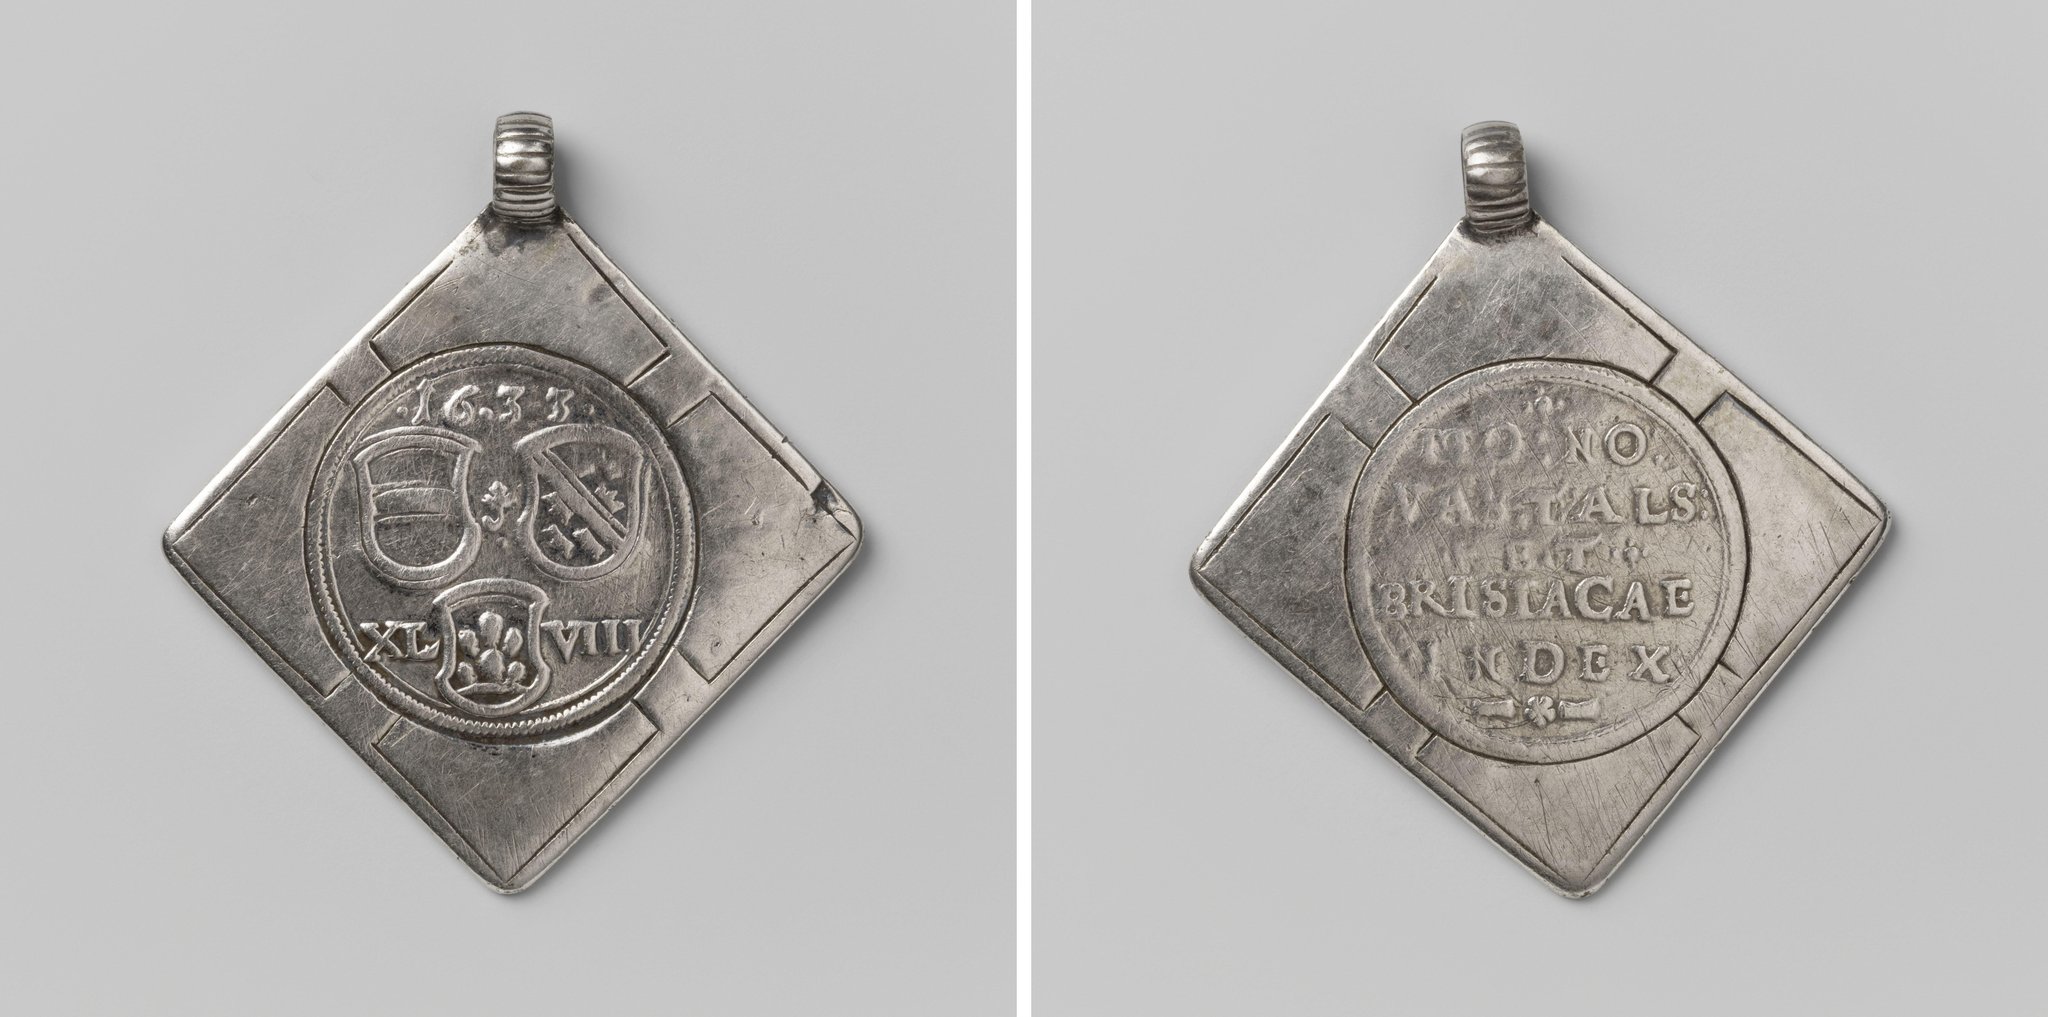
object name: siege coin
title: Achtenveertig batz, noodmunt uit Breisach, geslagen tijdens het beleg door de Zweden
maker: Anonymous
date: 1633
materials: silver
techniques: striking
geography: breisach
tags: breisach, beleg van breisach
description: ruitvormige noodmunt met afgeronde hoeken aan draagoog. Voorzijde: in ronde stempel, met aan alle vier de zijden een gegraveerde punt: jaartal boven twee wapenschilden, gescheiden door klaverblaadje boven punt; daaronder: wapenschild tussen Romeinse cijfer XLVIII. Keerzijde: in ronde stempel, met aan alle vier de zijden een gegraveerde punt: opschrift